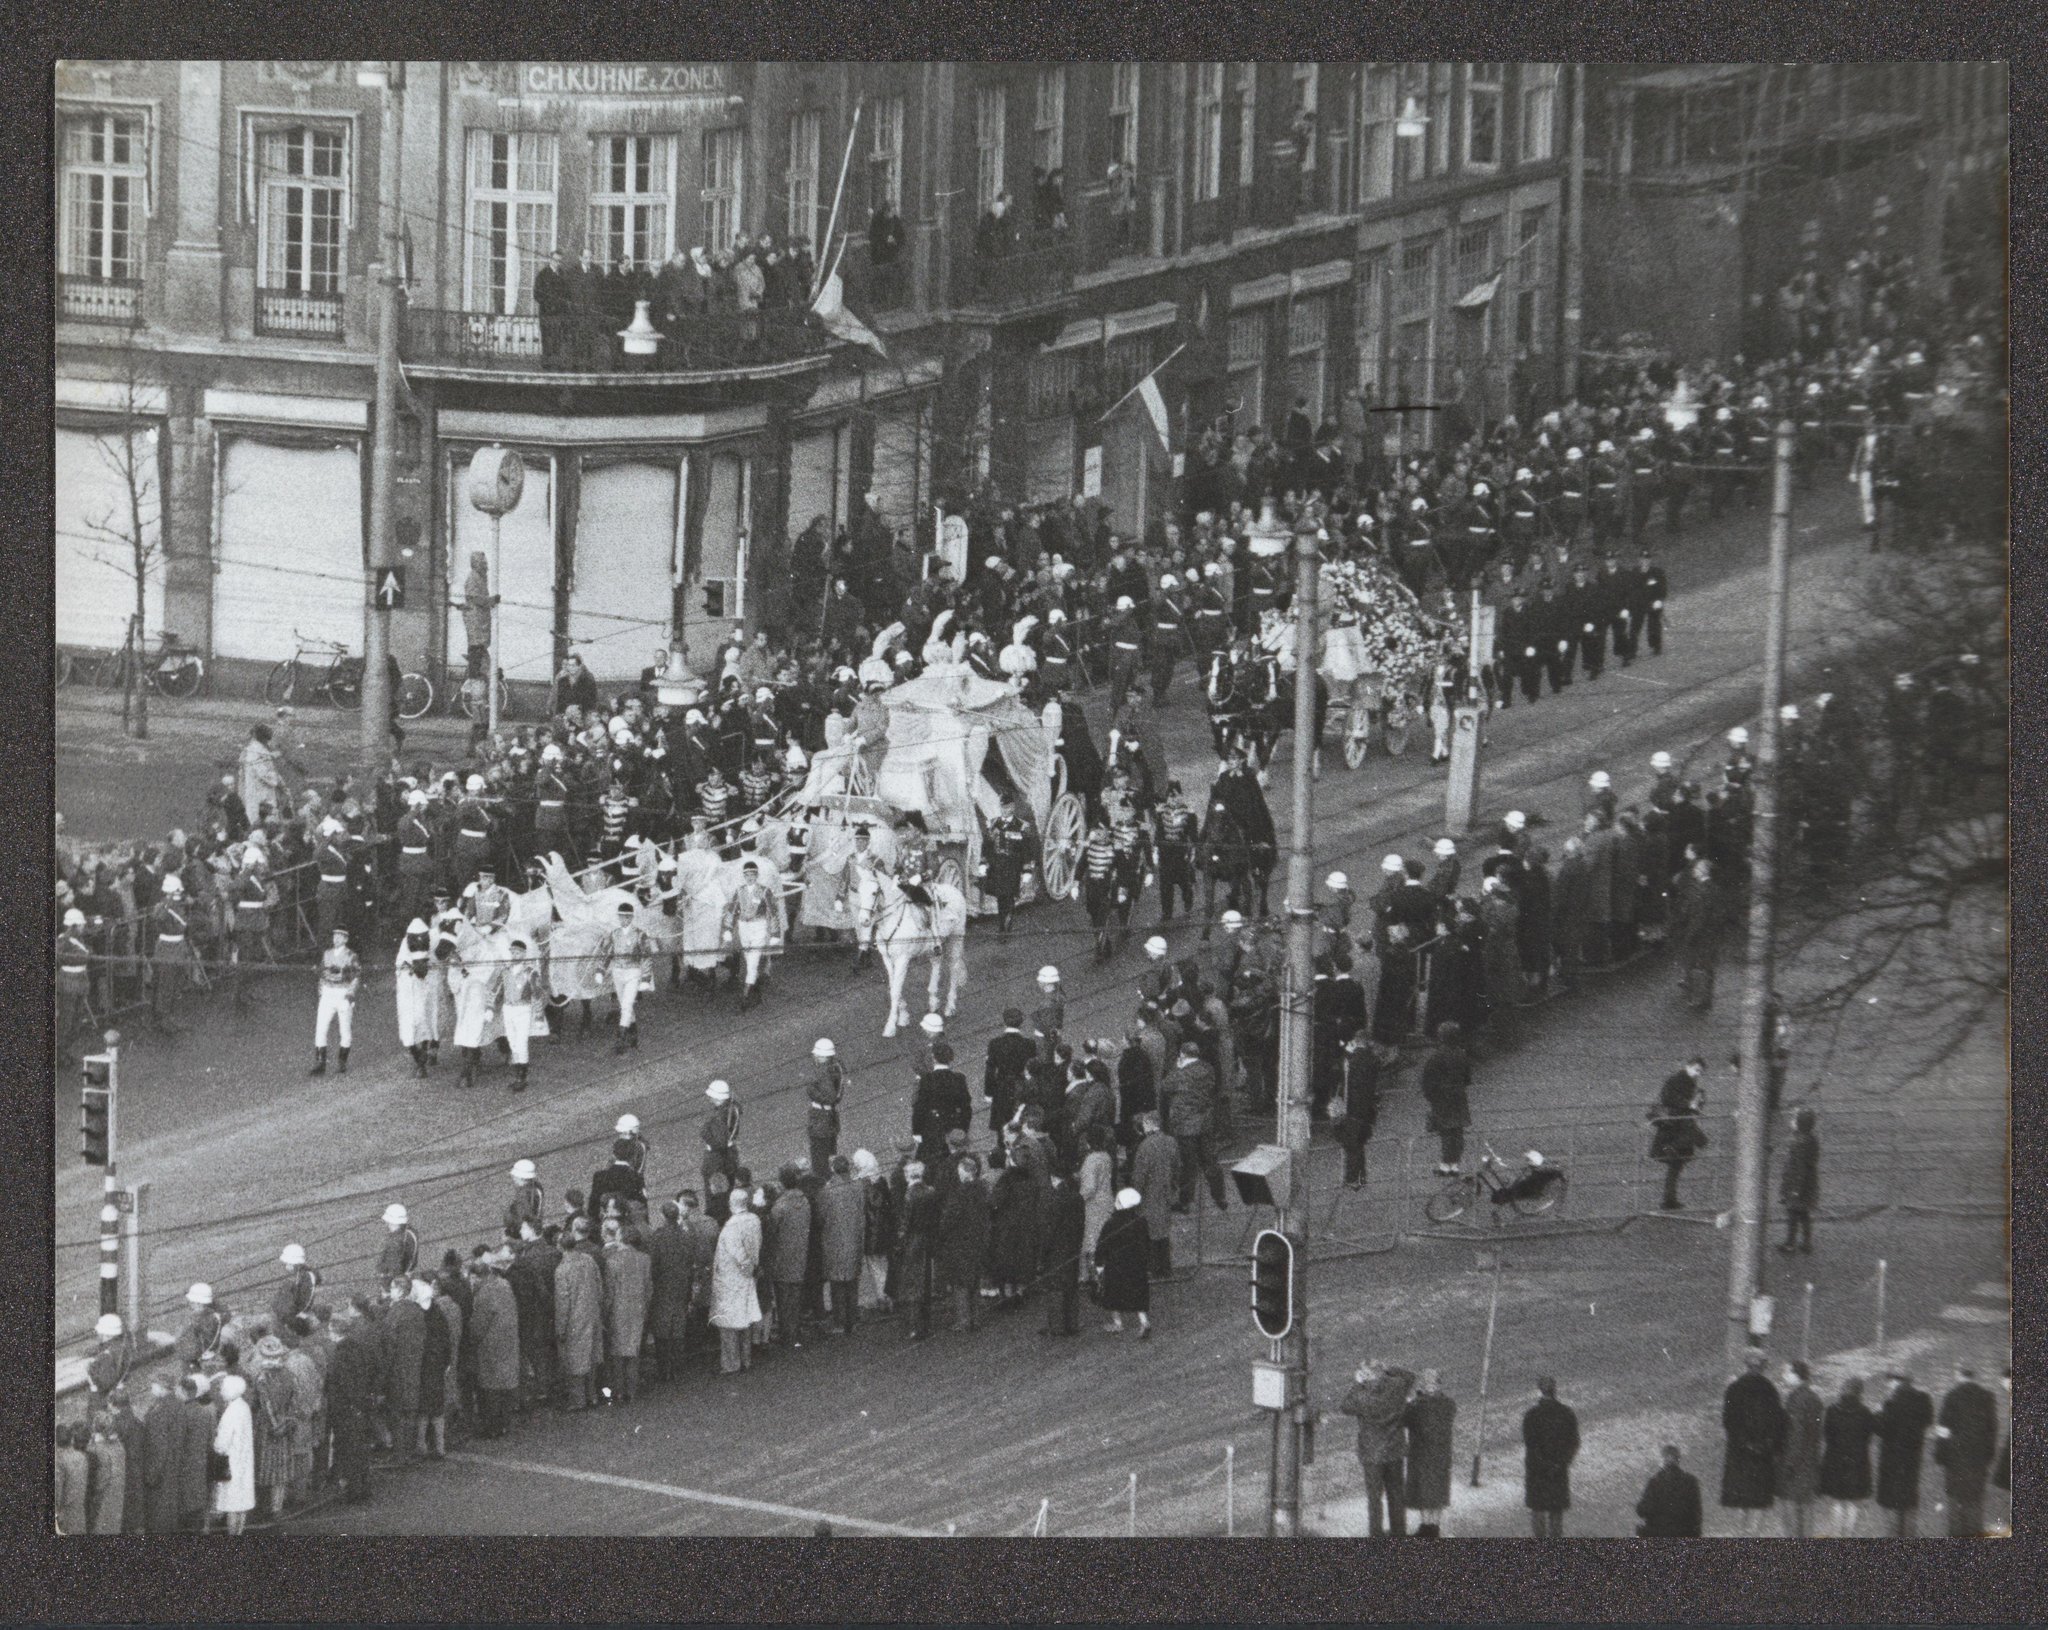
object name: photograph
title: Funeral of Princess Wilhelmina.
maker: Anonymous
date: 1962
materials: photographic support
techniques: gelatin silver print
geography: the hague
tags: print maker, wilhelmina of the netherlands, public funeral, the hague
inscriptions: inscription: ‘To-day the coffin with the mortal remains of HRH Princess Wilhelmina has been removed from the Palace Lange Voorhout at the Hague to the New Church at Delft, where Pr. Wilhelmina has been entombed’, inscription: ‘Photo: The coach with the mortal remains with 8 horses, all in white, behind the cach a coach with flowers and wreaths in the Kneuterdijk in The HAgue on their way to Delft. Foto Anefo 8-12-1962’